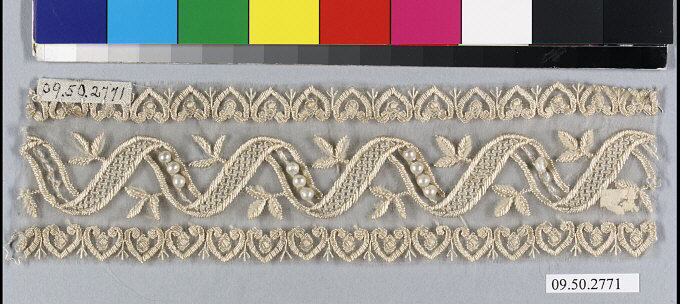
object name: border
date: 1801-1900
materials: silk, wool